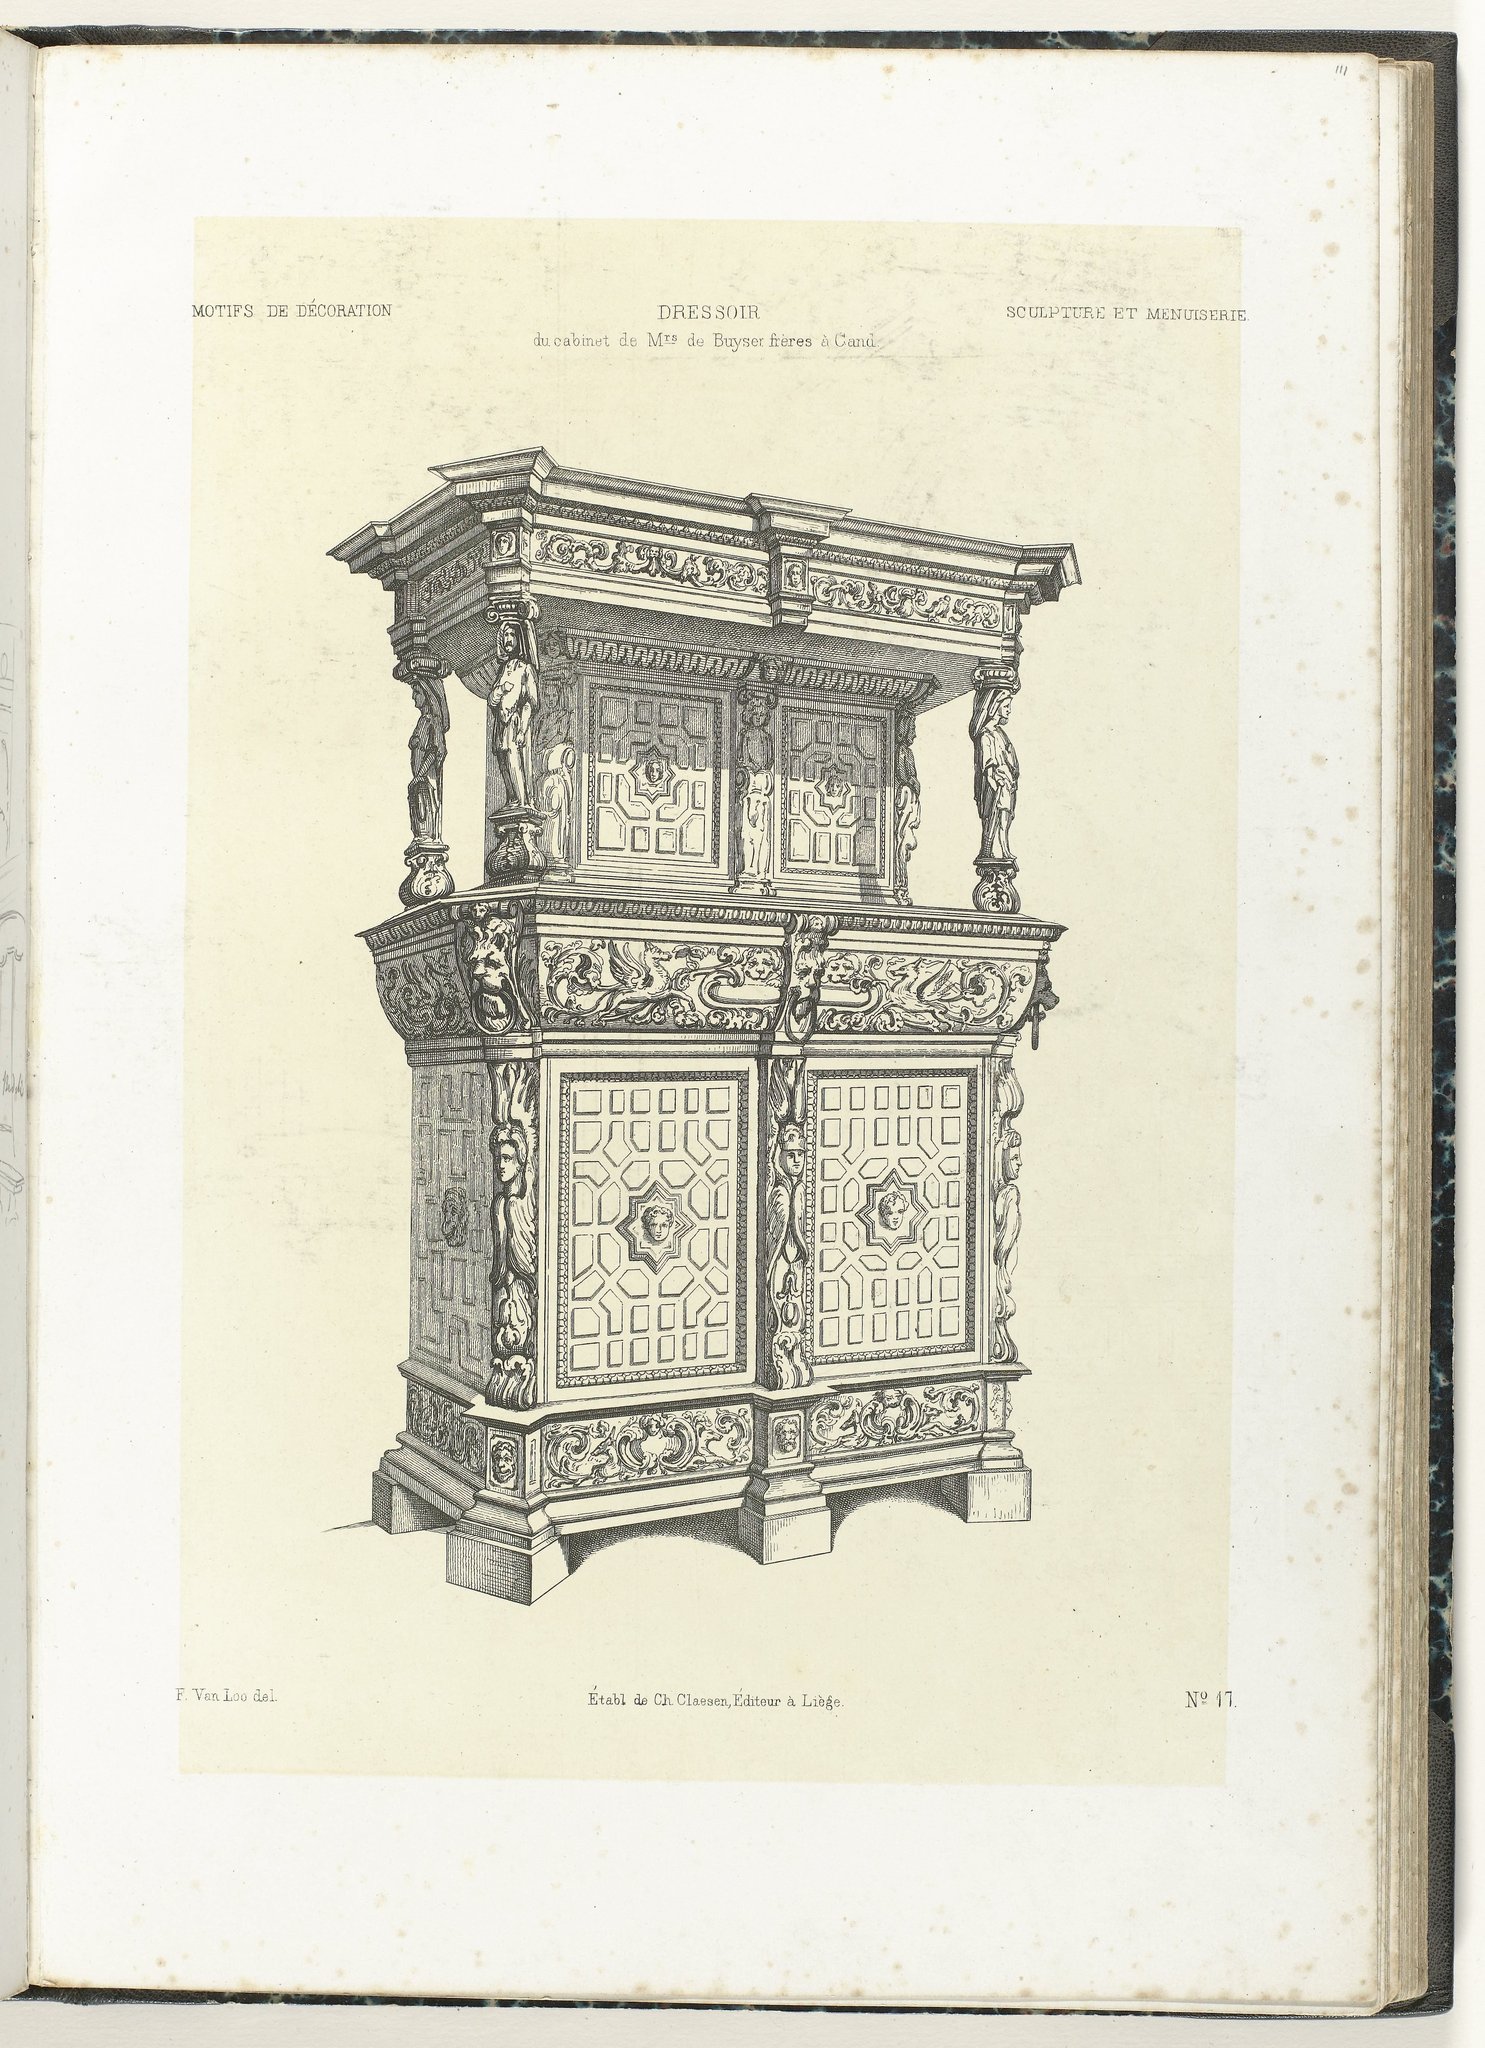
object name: print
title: Buffetkast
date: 1866-1900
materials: paper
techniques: tone lithography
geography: liège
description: De deuren en zijkanten van de buffetkast zijn gedecoreerd met maskers in een stervorm. Linksboven staat vermeld: Motifs de décoration, rechtsboven: Sculpture et menuiserie, rechtsonder: N° 17.